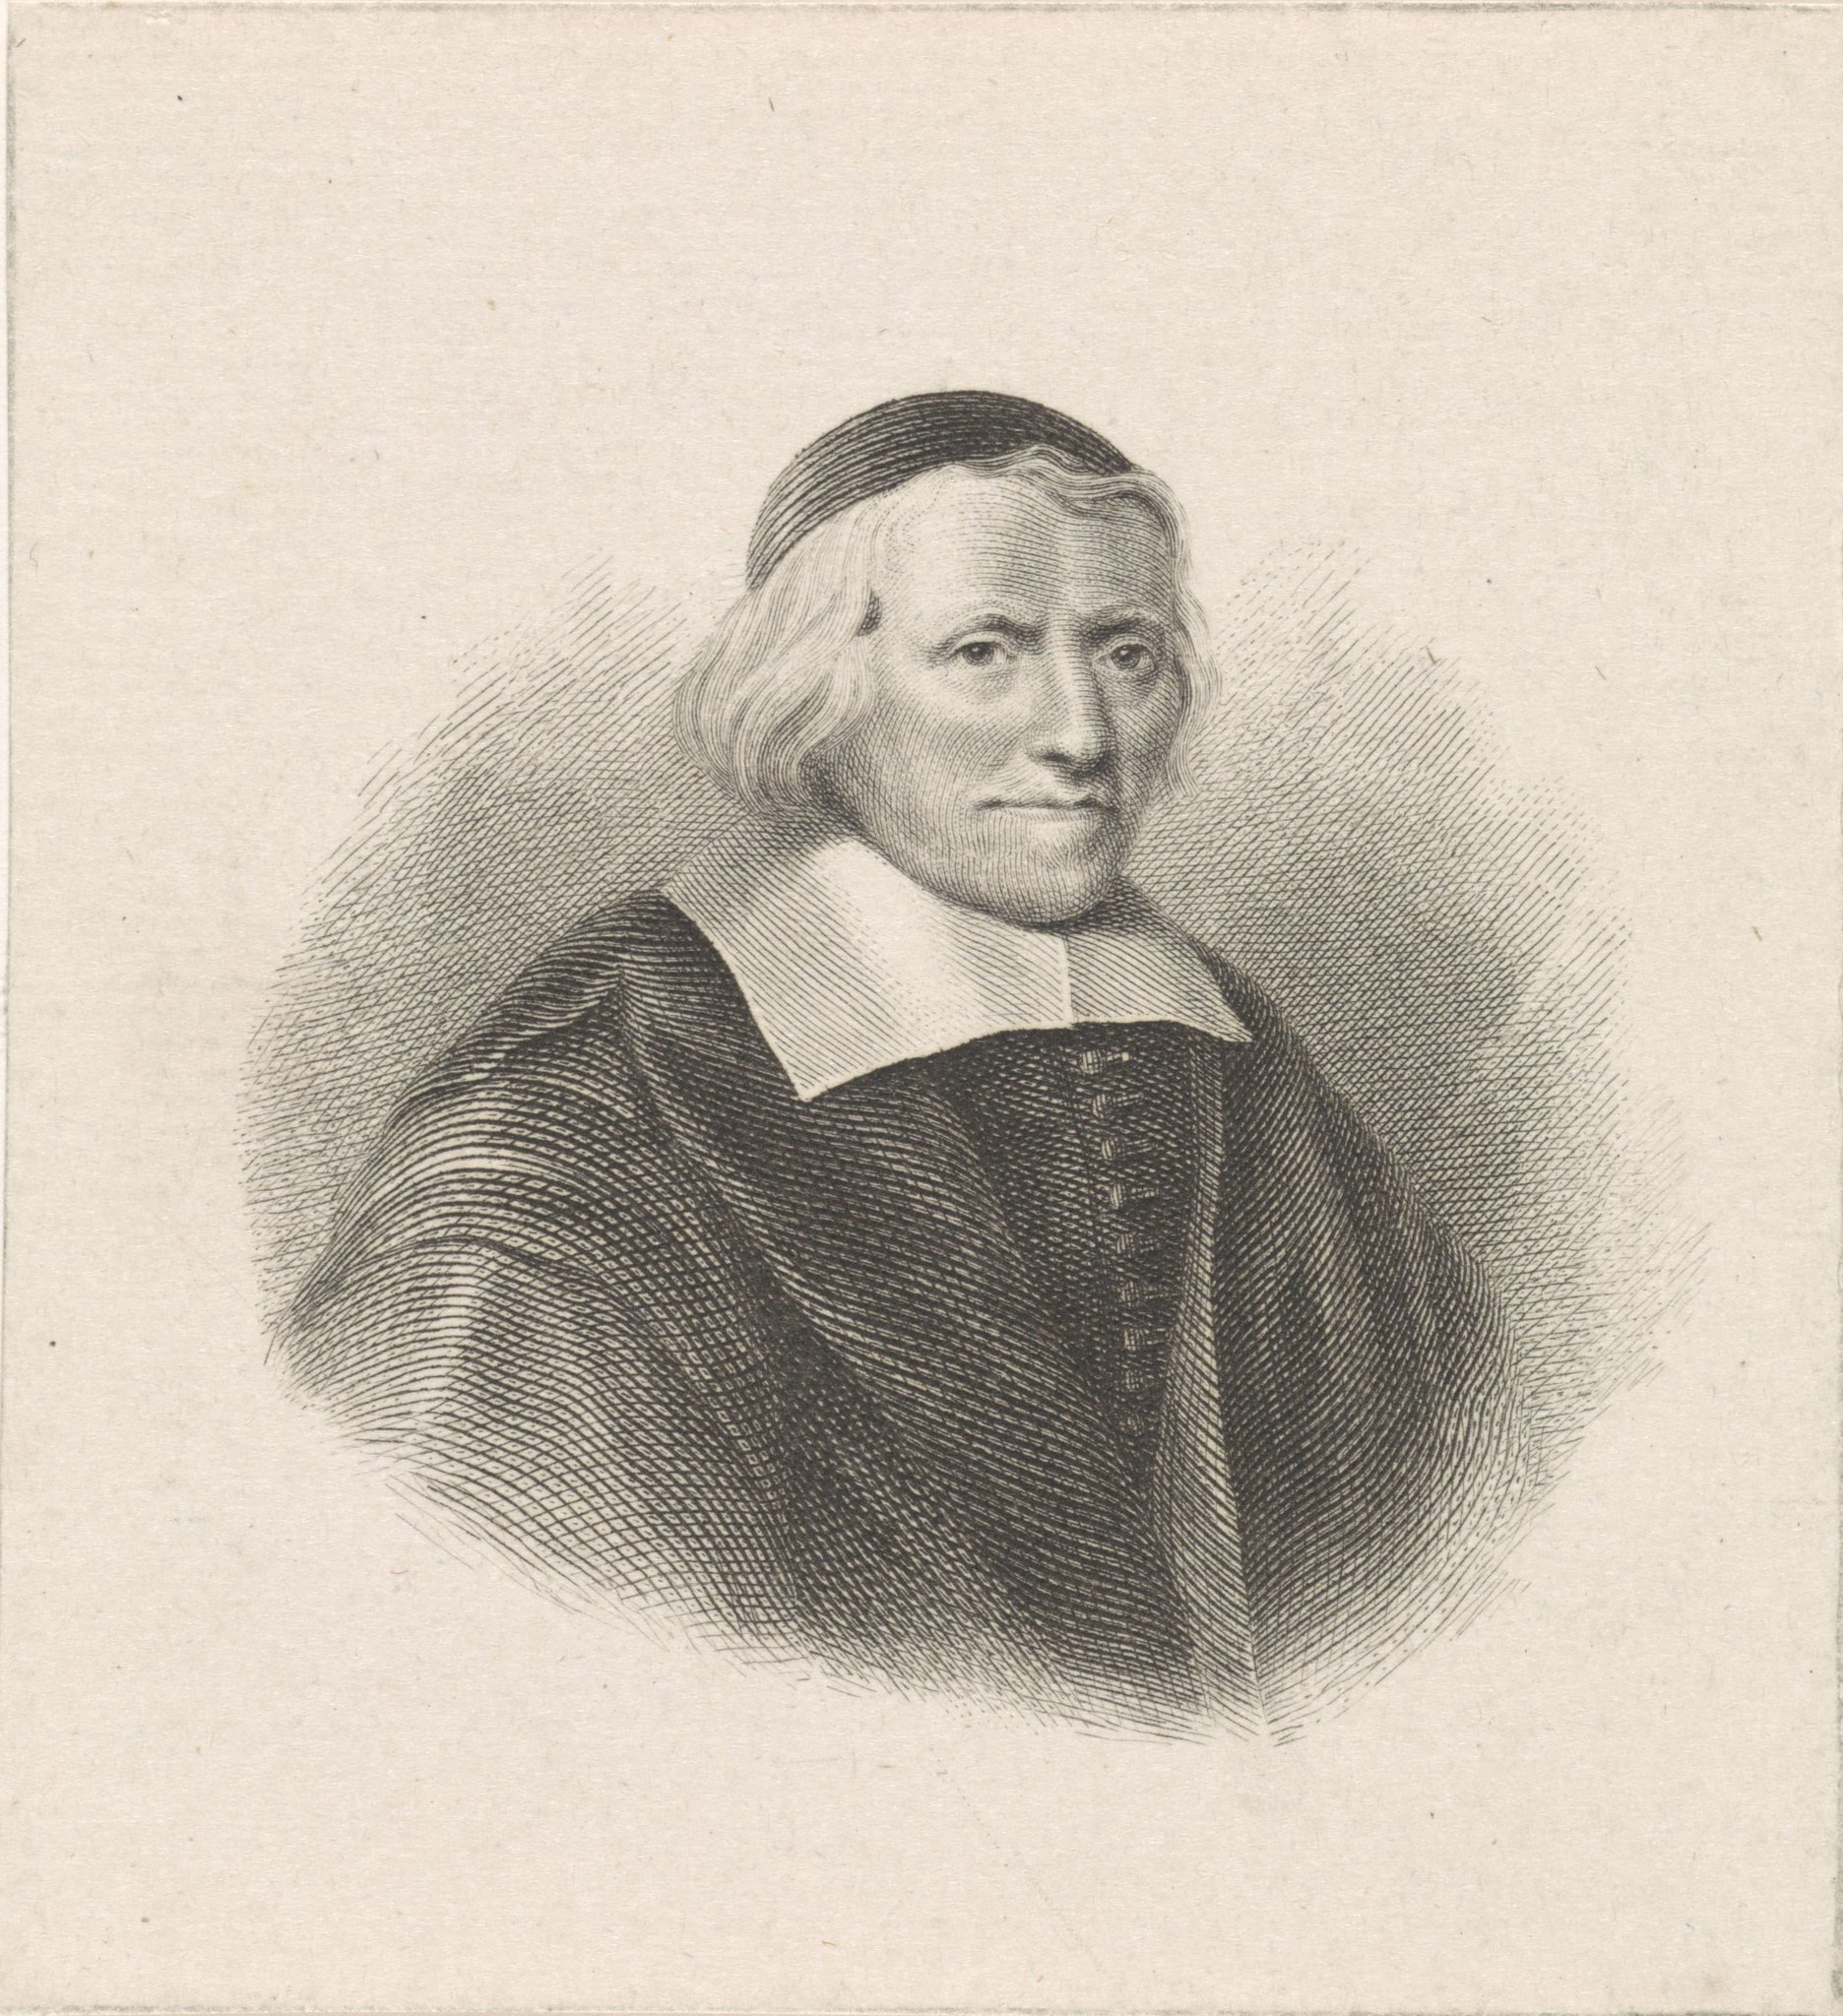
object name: print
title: Portret van de dichter Jacob Cats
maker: willem van senus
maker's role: painter, print maker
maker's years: 1773-1851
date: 1783-1851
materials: paper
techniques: engraving, etching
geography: netherlands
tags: the hague, jacob cats (1577-1660), historical persons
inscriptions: collector's mark: Lugt 2228, name: ‘Cats’